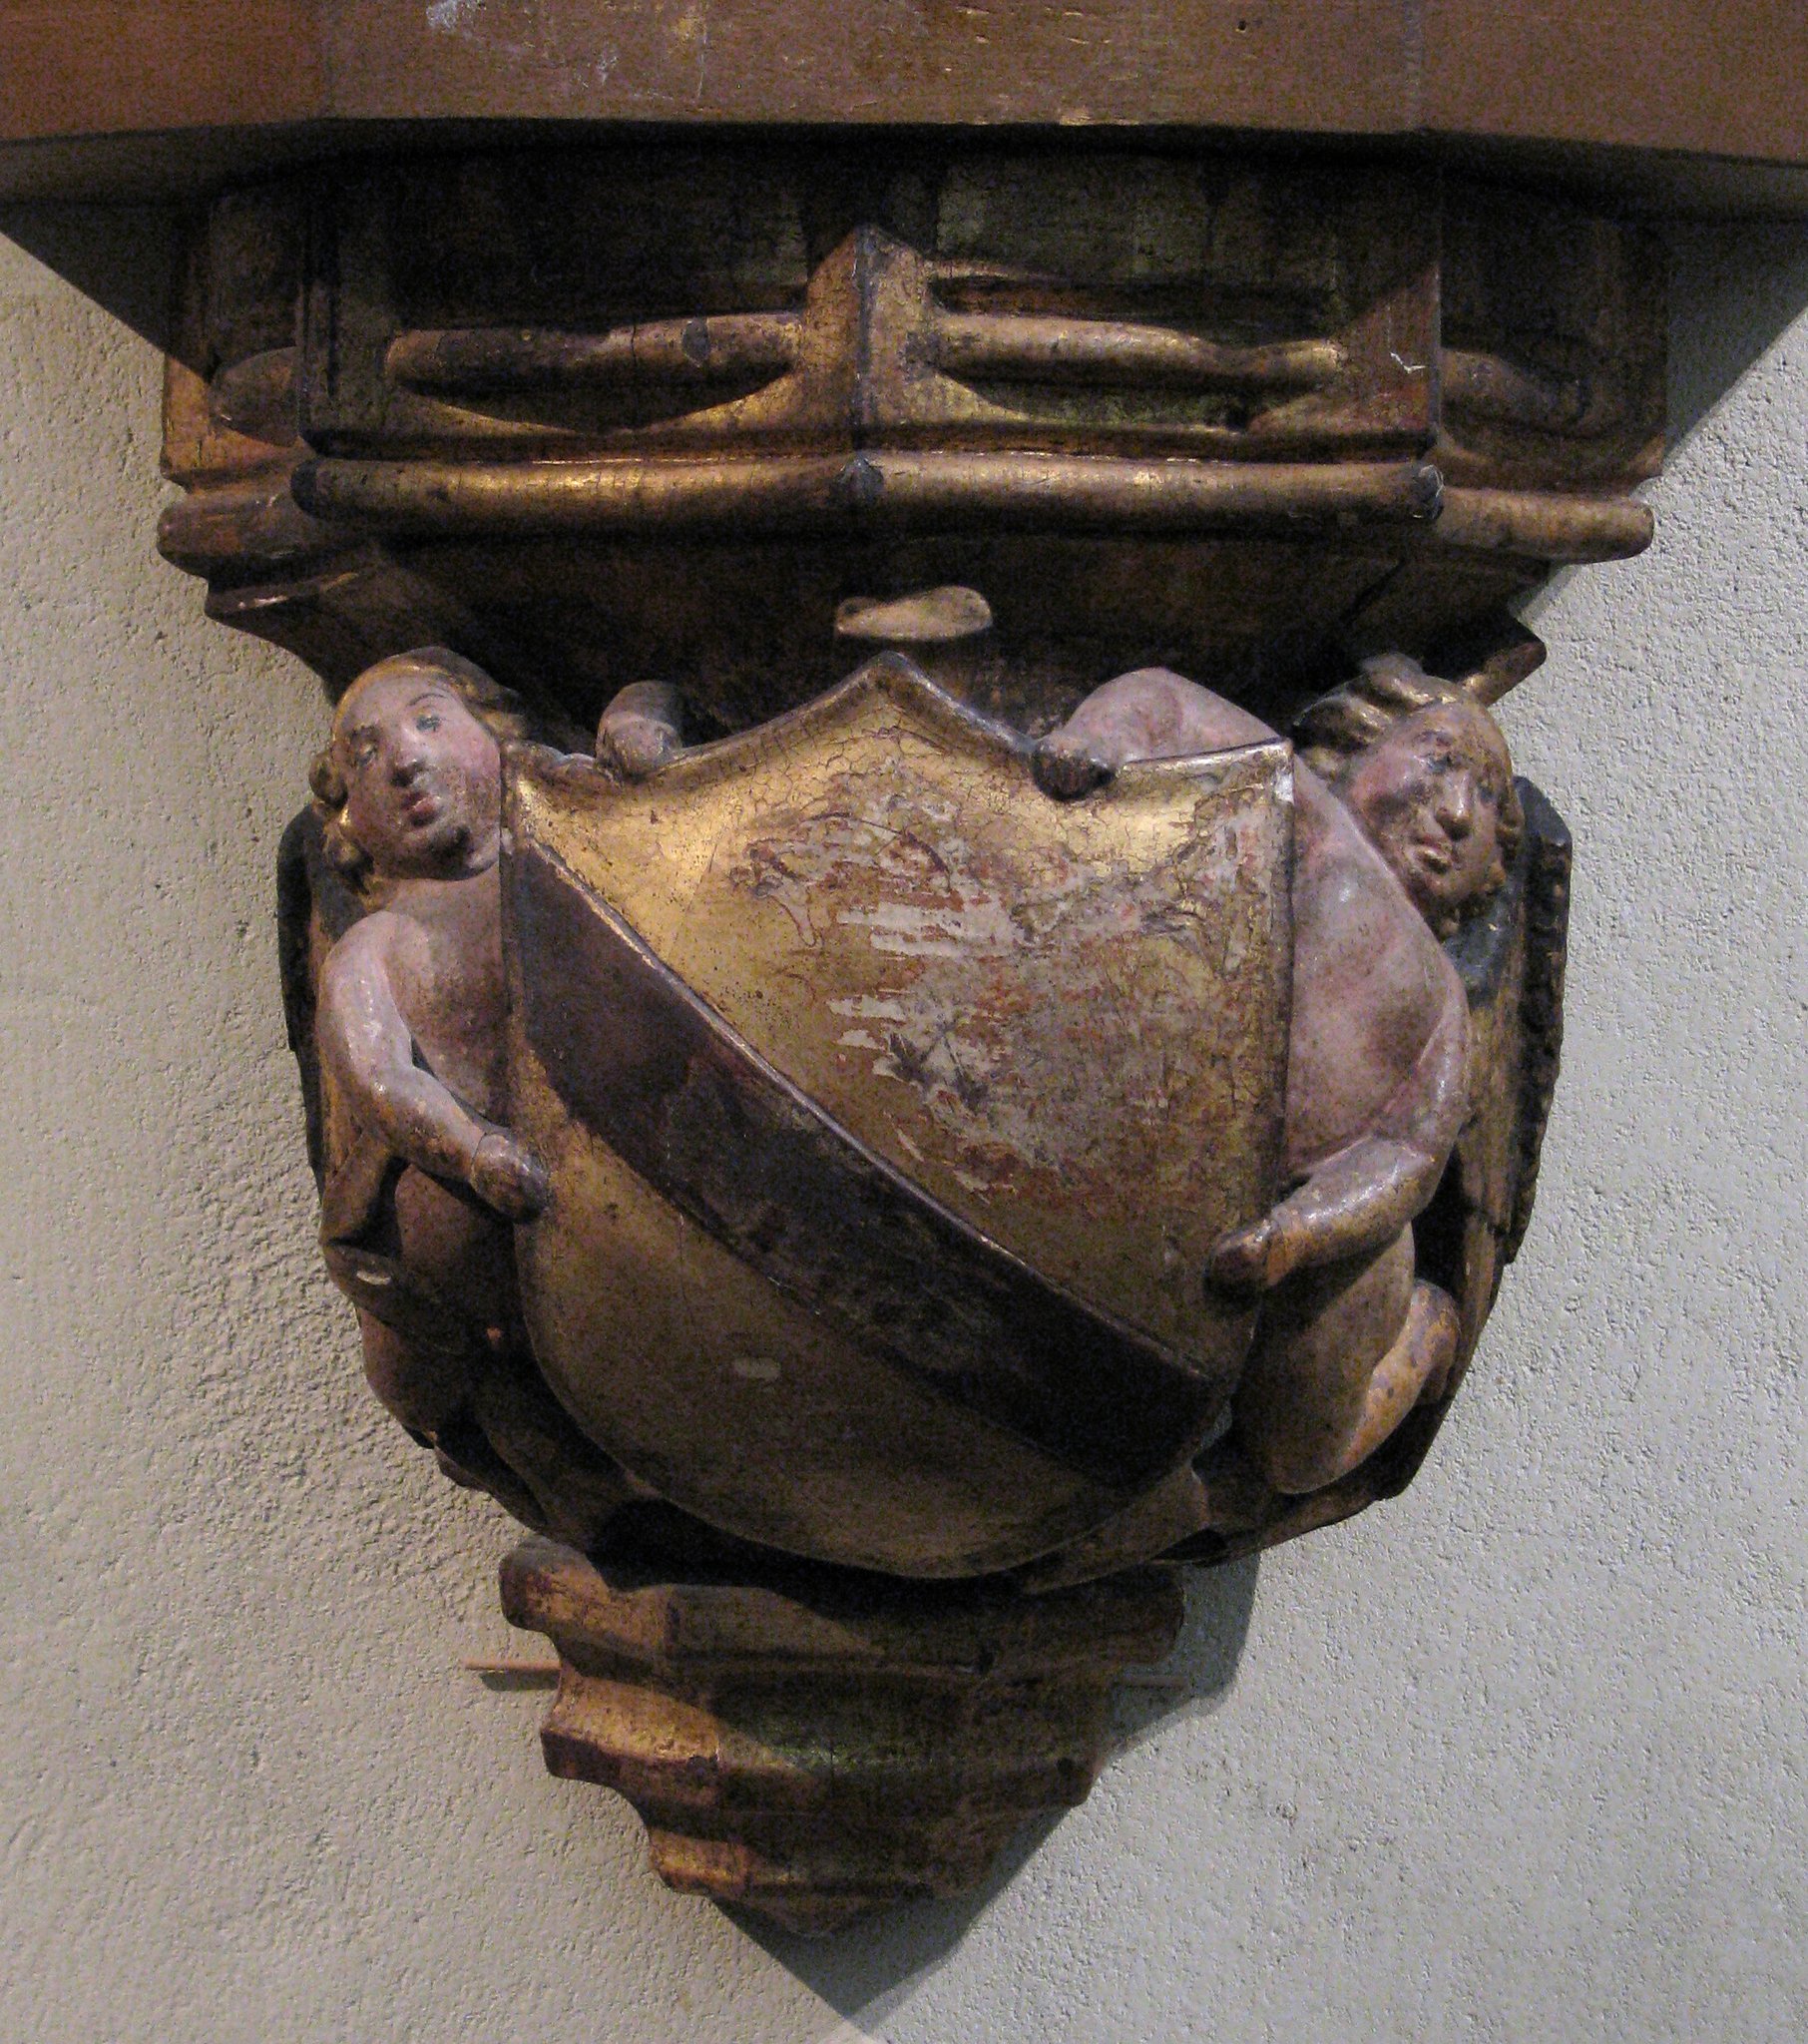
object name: corbel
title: Corbel with Angels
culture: french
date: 1467-1500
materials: paint, wood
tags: coat of arms